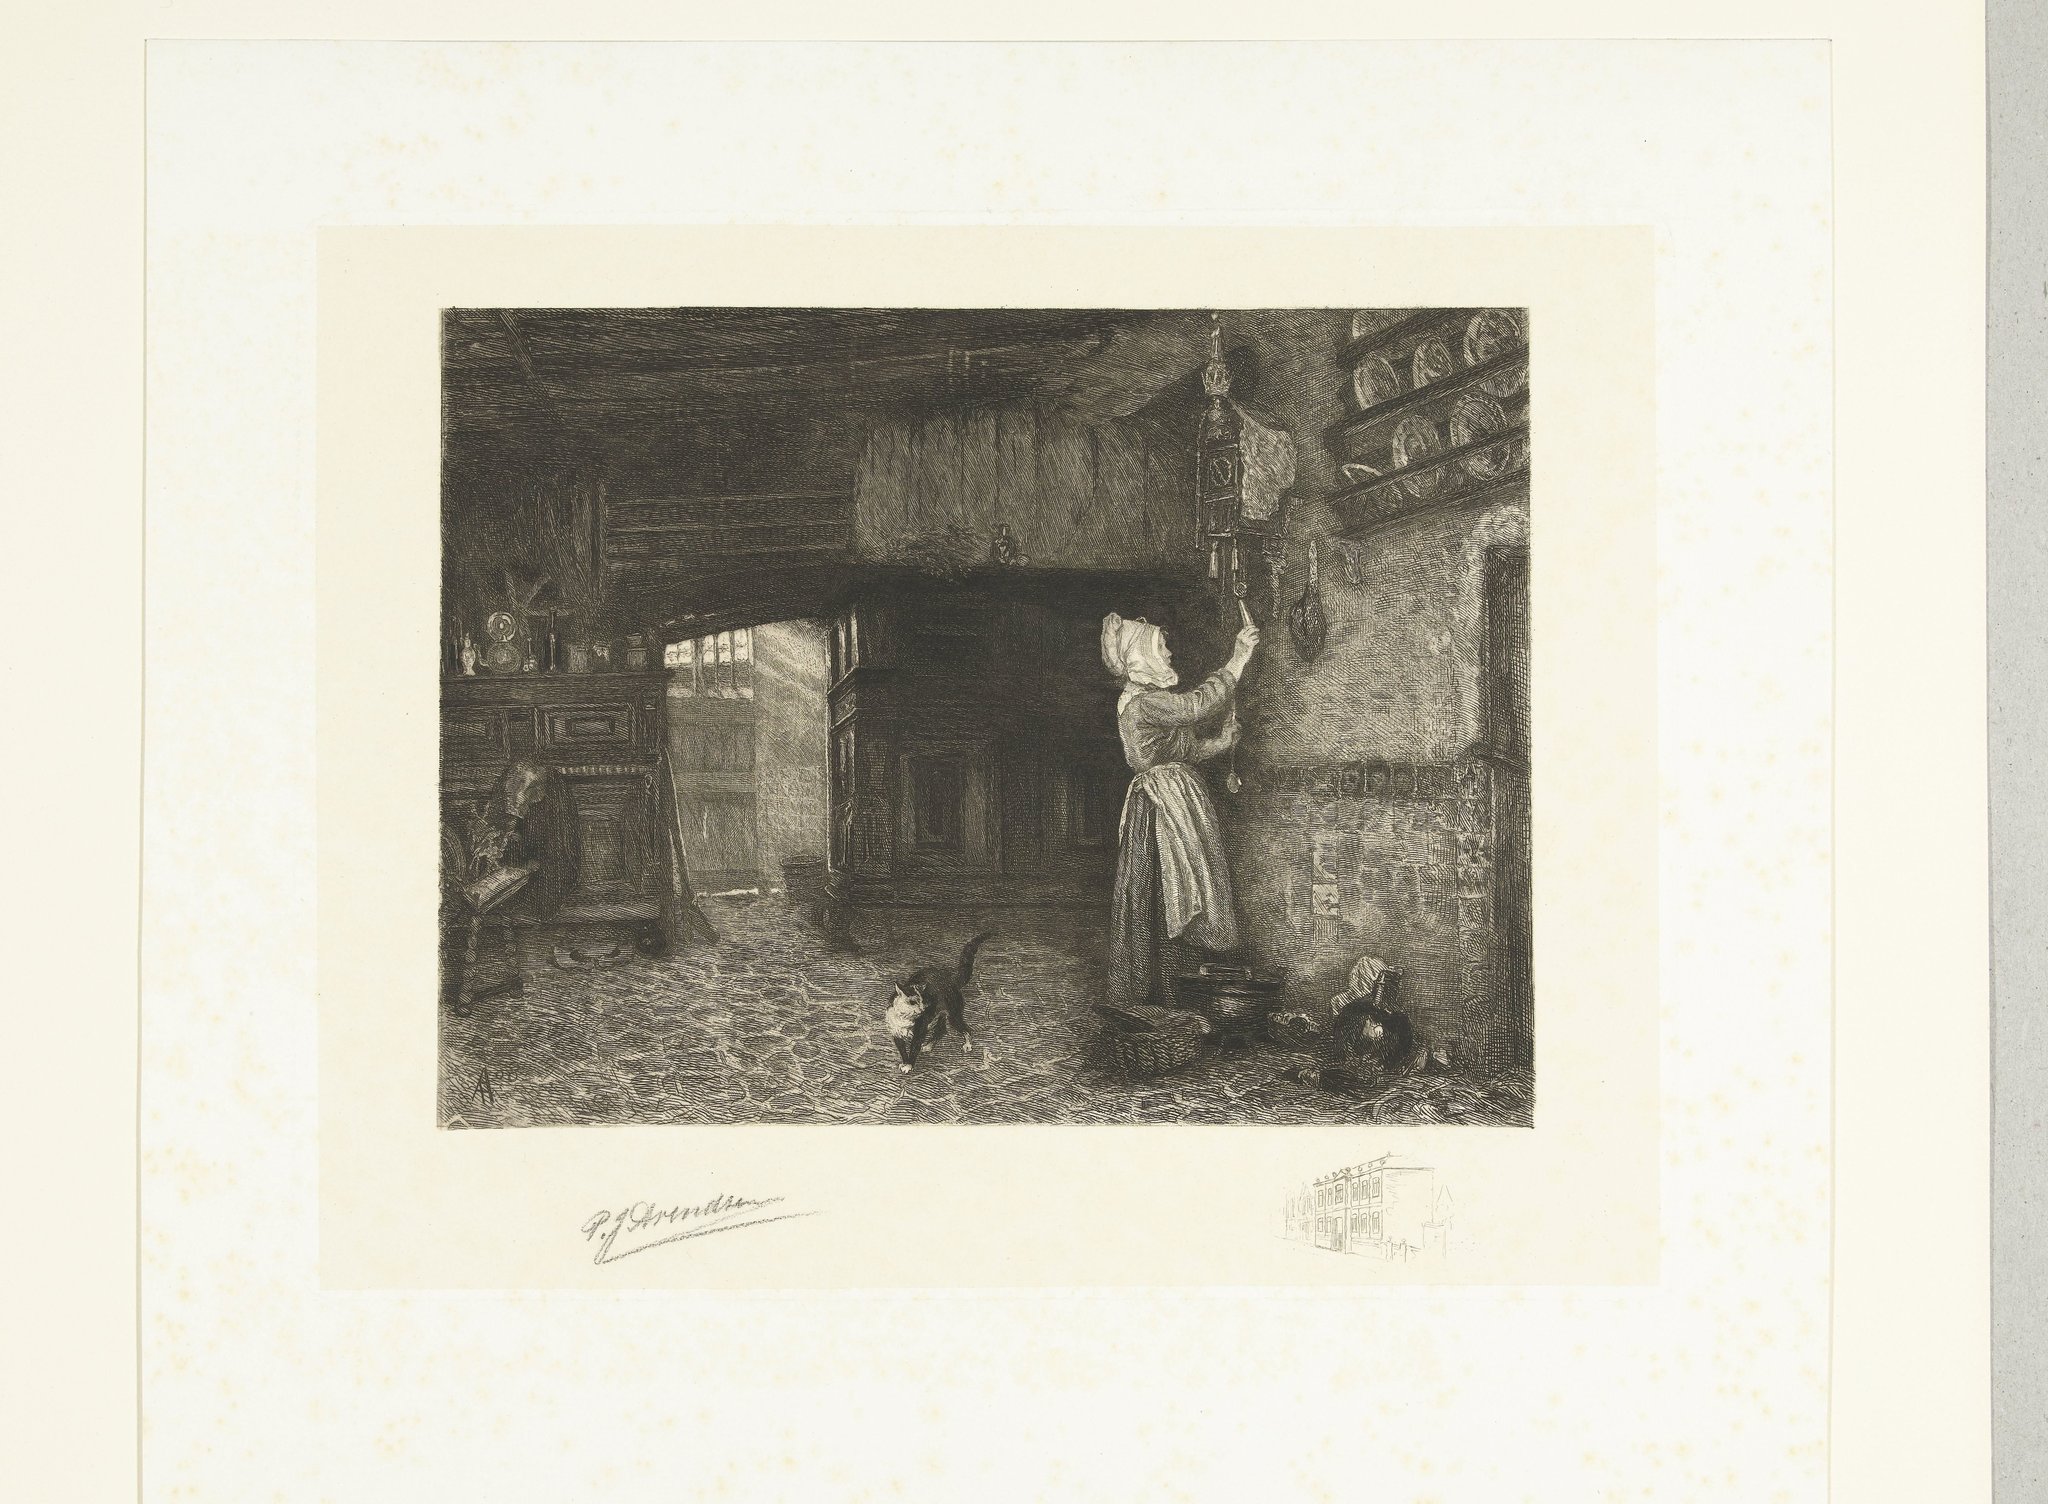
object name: print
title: Vrouw die een wandklok opwindt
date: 1908-1909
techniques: printmaking, etching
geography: netherlands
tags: kitchen-interior, watch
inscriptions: collector's mark: Lugt 2228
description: Keukeninterieur met vrouw die een wandklok opwindt. In marge een rij stadshuizen.